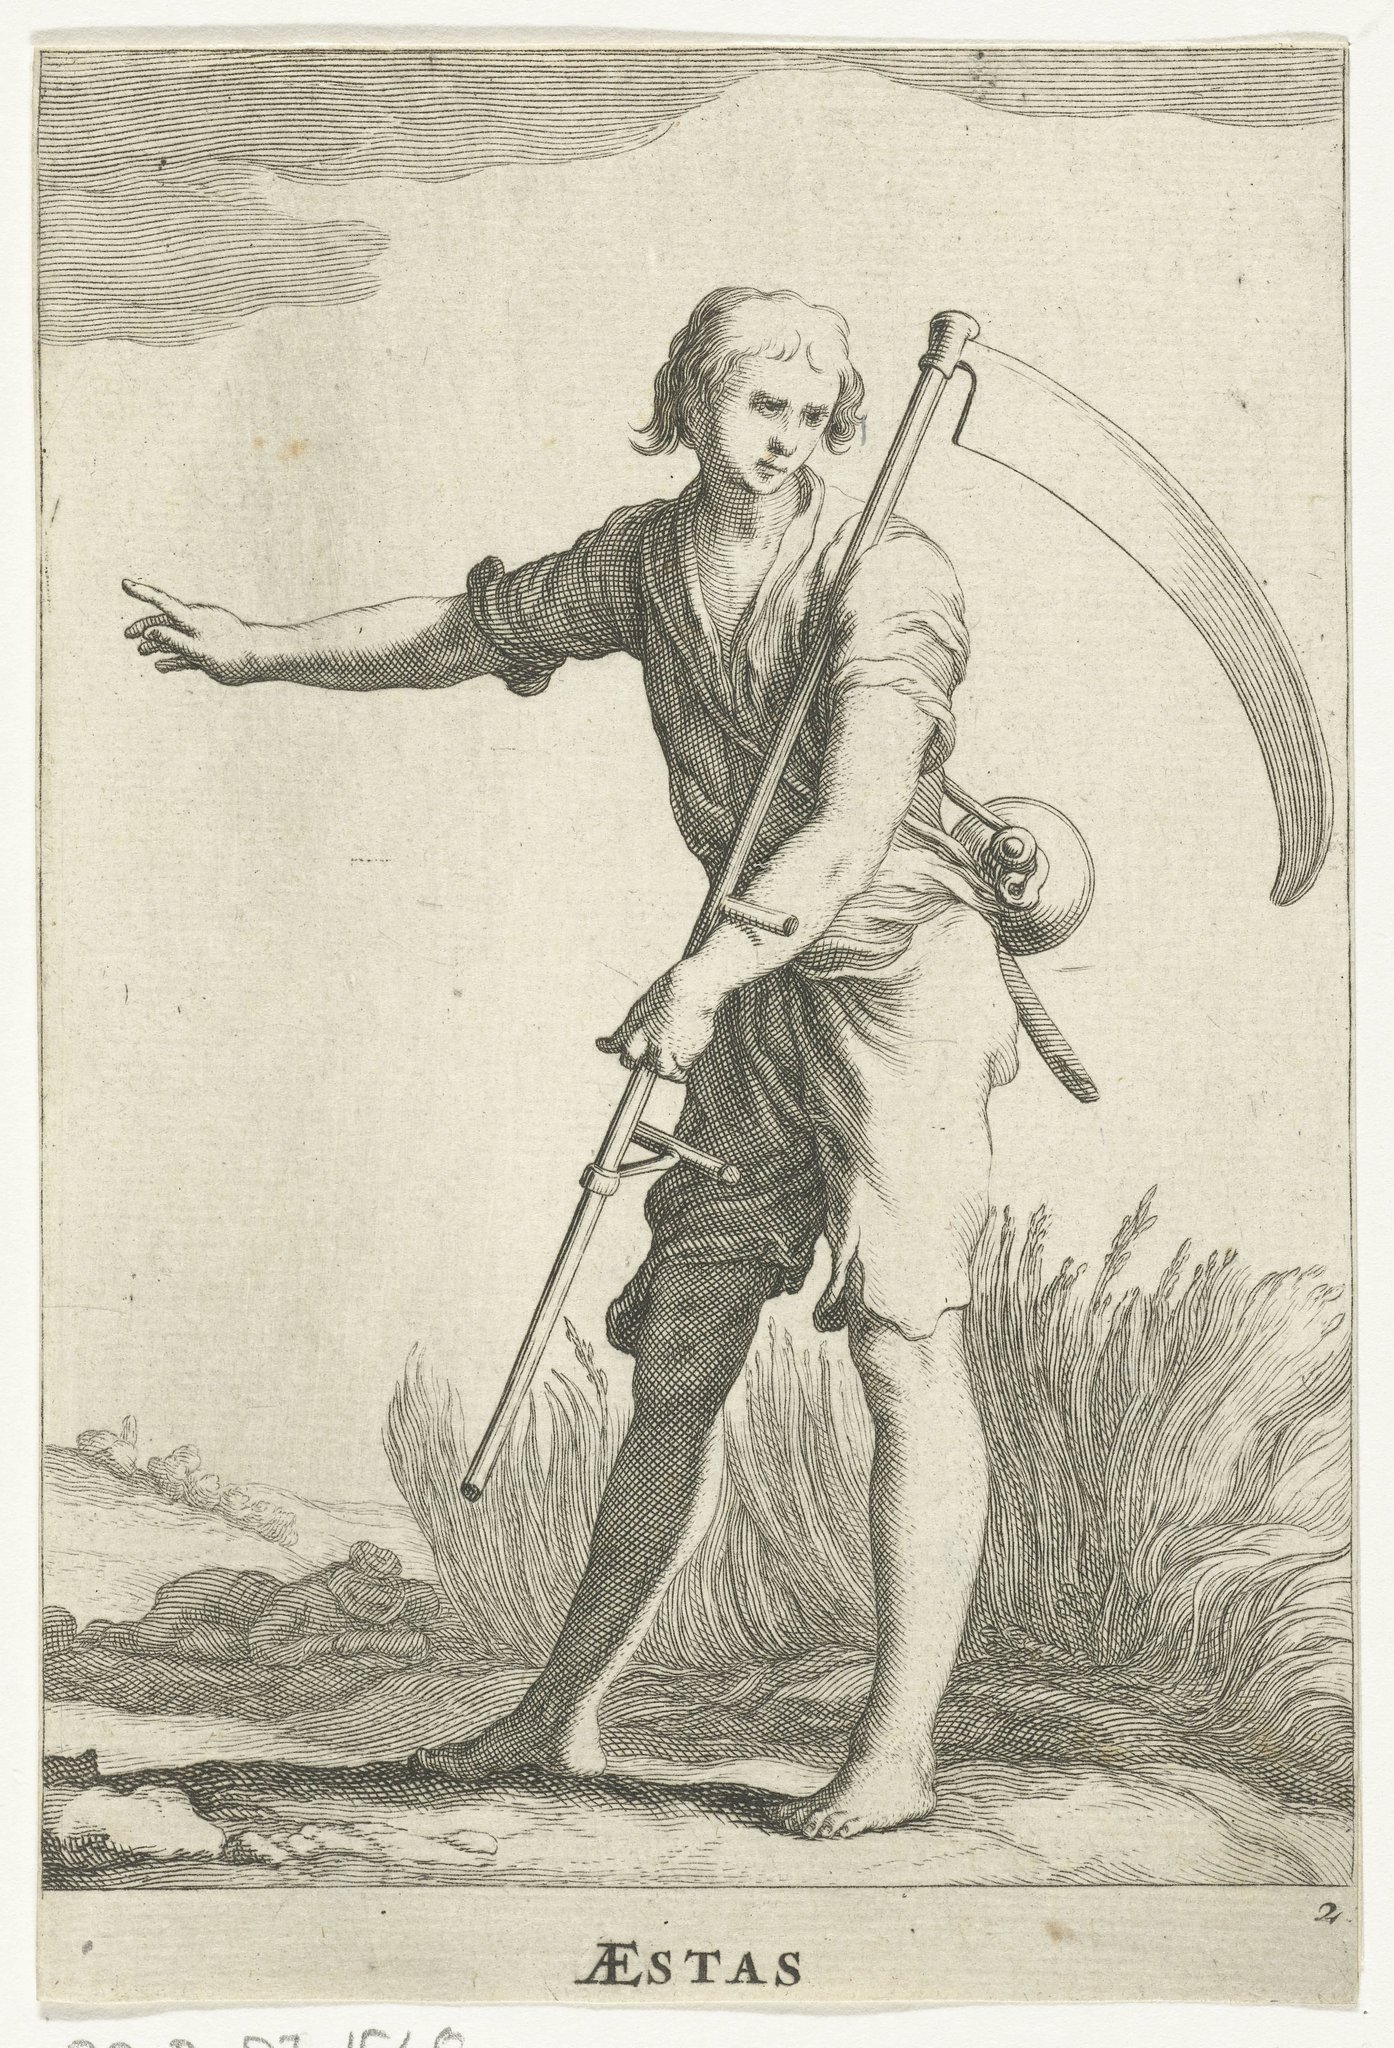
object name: print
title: Zomer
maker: frederick bloemaert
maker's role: print maker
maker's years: 1614-1669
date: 1632-1670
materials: paper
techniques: engraving, etching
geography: utrecht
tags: agricultural implements: scythe, summer, 'aestas'; 'estate' (ripa)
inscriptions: collector's mark: Lugt 240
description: Een maaier met een zeis in zijn hand wijst naar het veld.